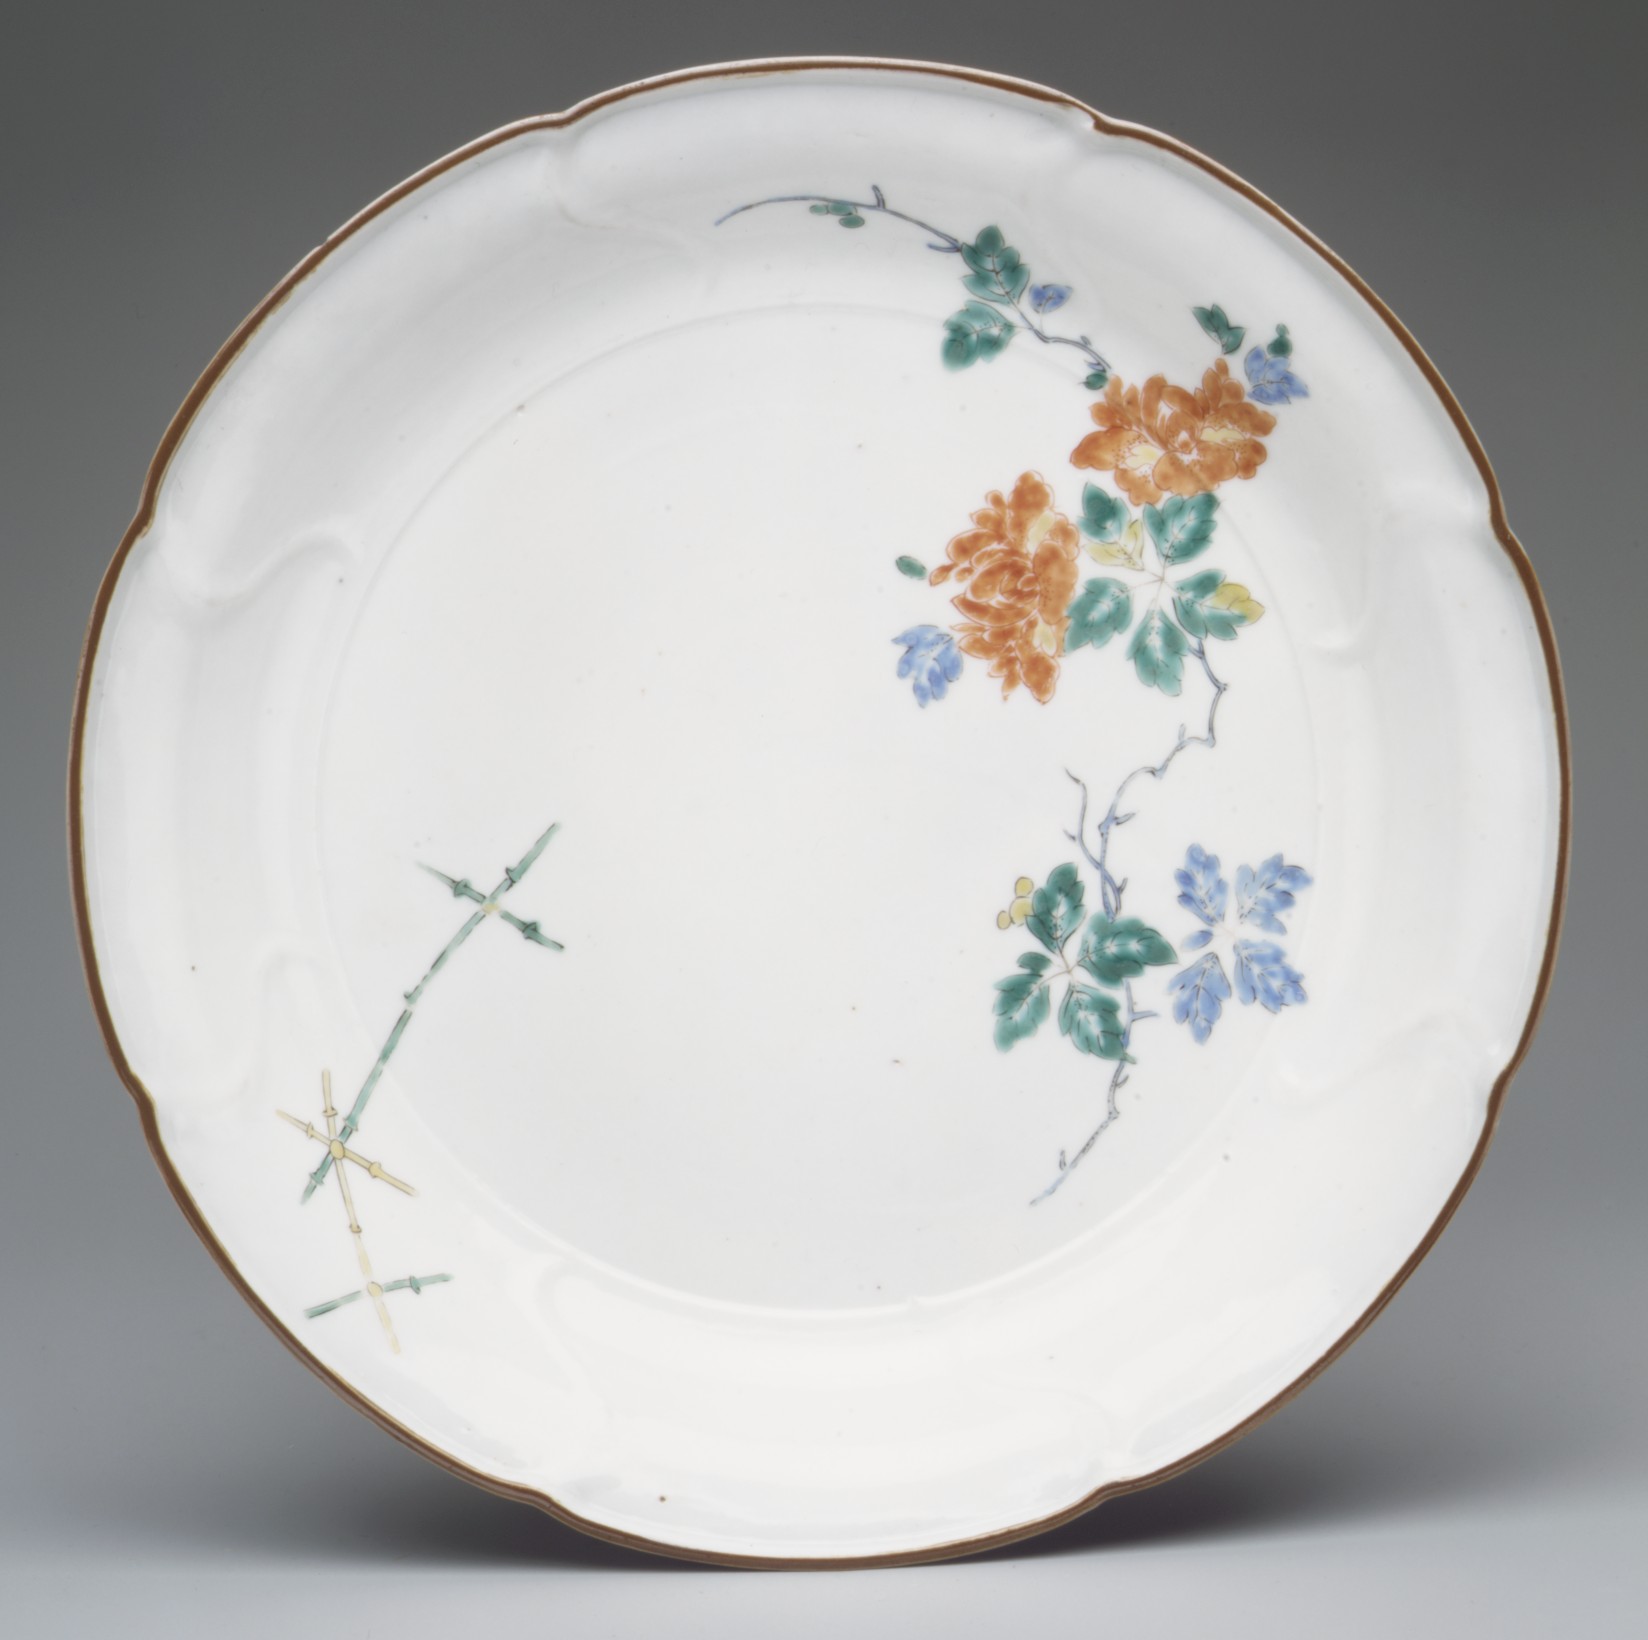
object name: dish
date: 1701-1733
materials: hard paste porcelain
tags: flowers